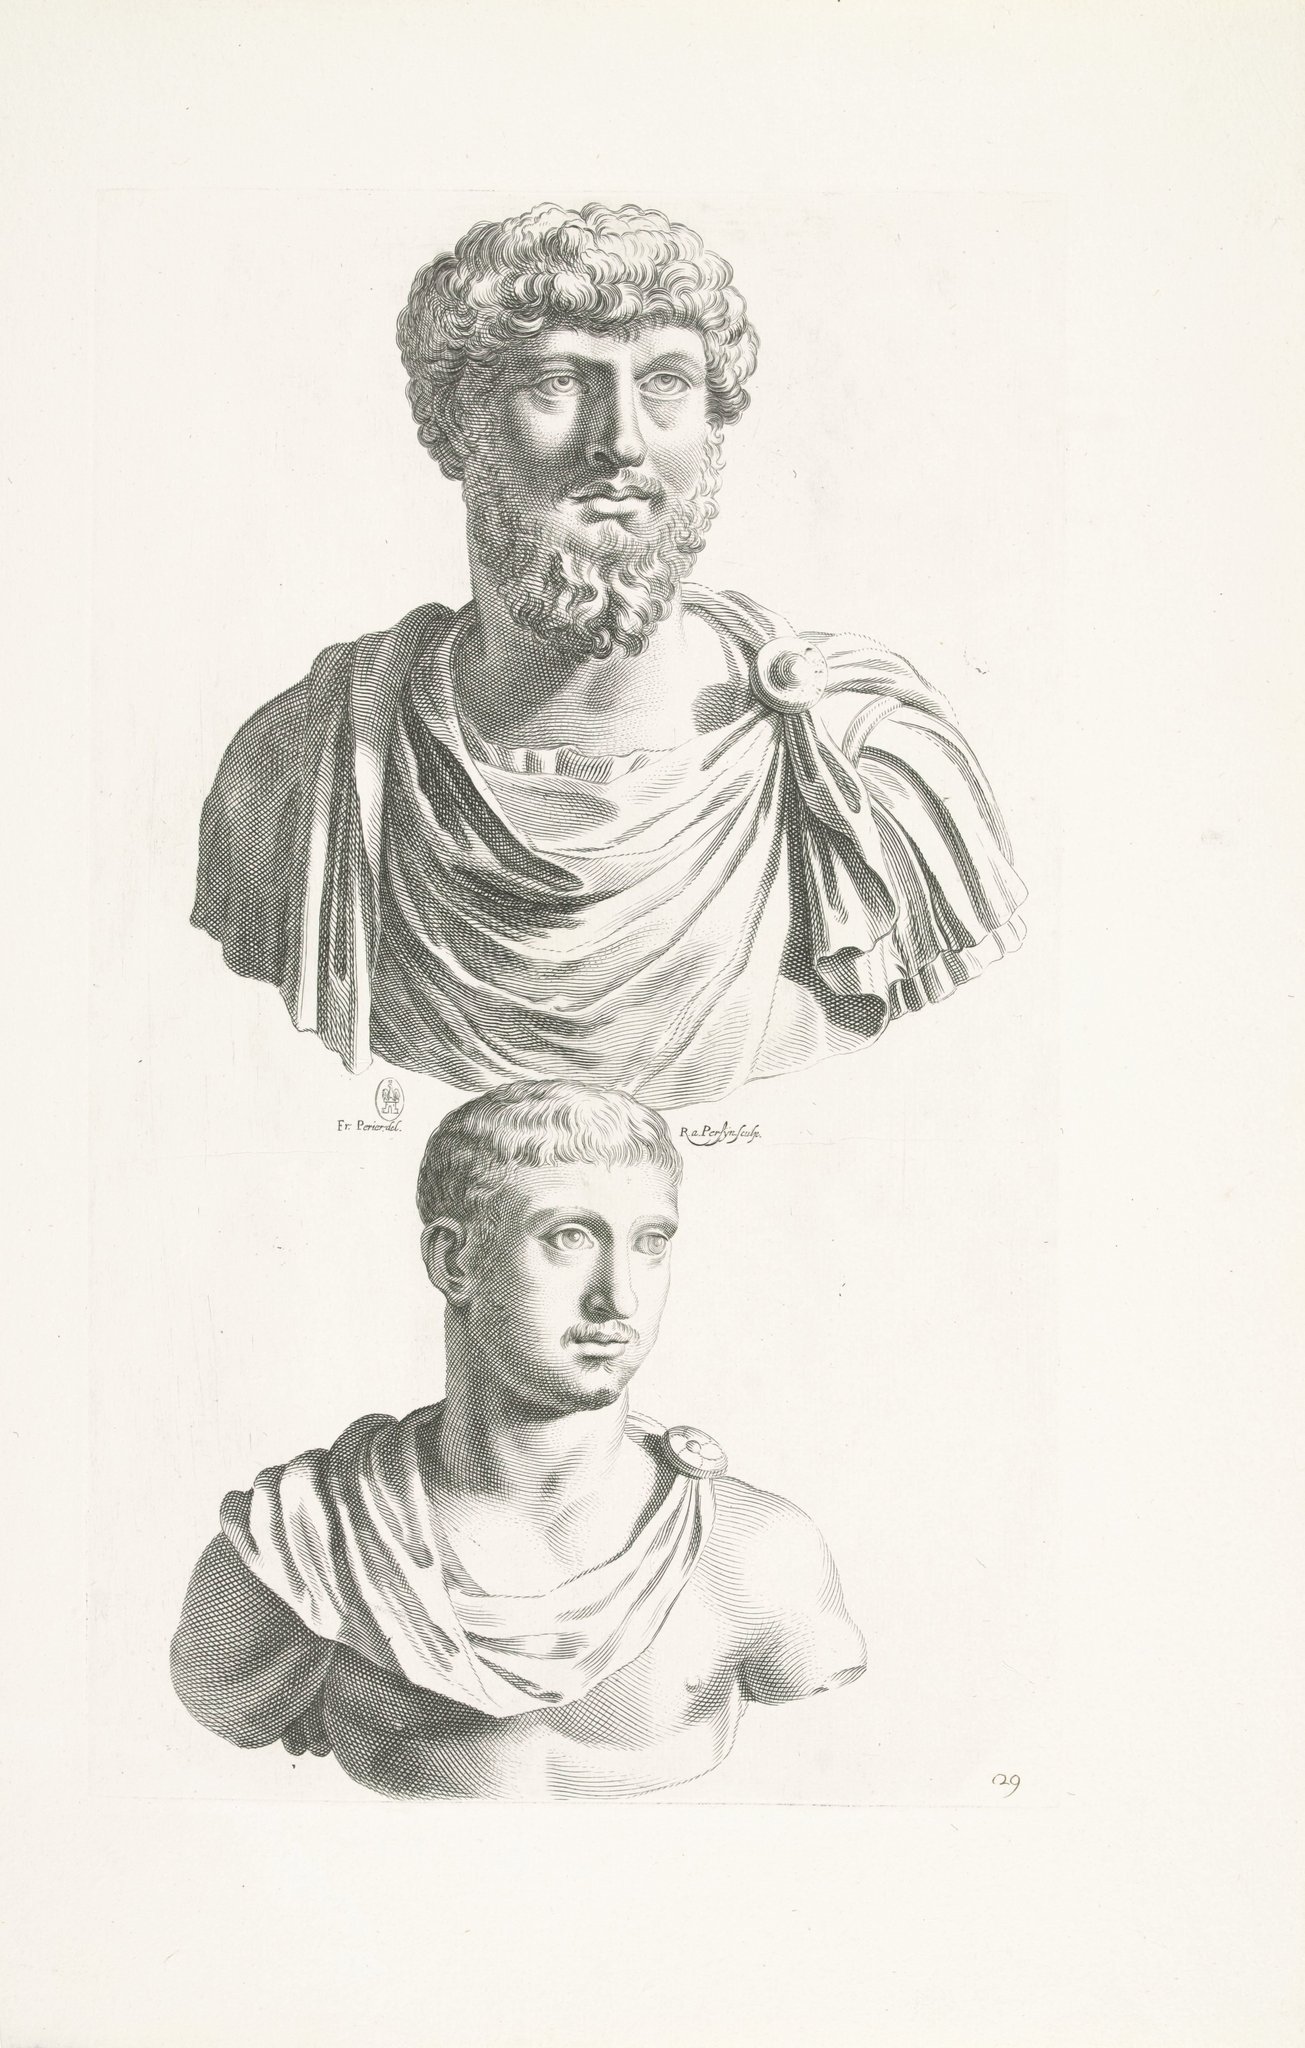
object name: print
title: Galleria Giustiniana del Marchese Vincenzo Giustiniani II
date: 1640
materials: paper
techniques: engraving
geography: rome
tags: vincenzo giustiniani (1564-1637), piece of sculpture, reproduction of a piece of sculpture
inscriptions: collector's mark: Lugt 2228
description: Twee Romeinse portretbustes van keizer Lucius Verus en keizer Alessandro Severo. In het midden het wapenschild van Vincenzo Giustiniani. Prent uit een publicatie met reproductieprenten naar de sculpturen in de verzameling in de Galleria Giustiniani te Rome.